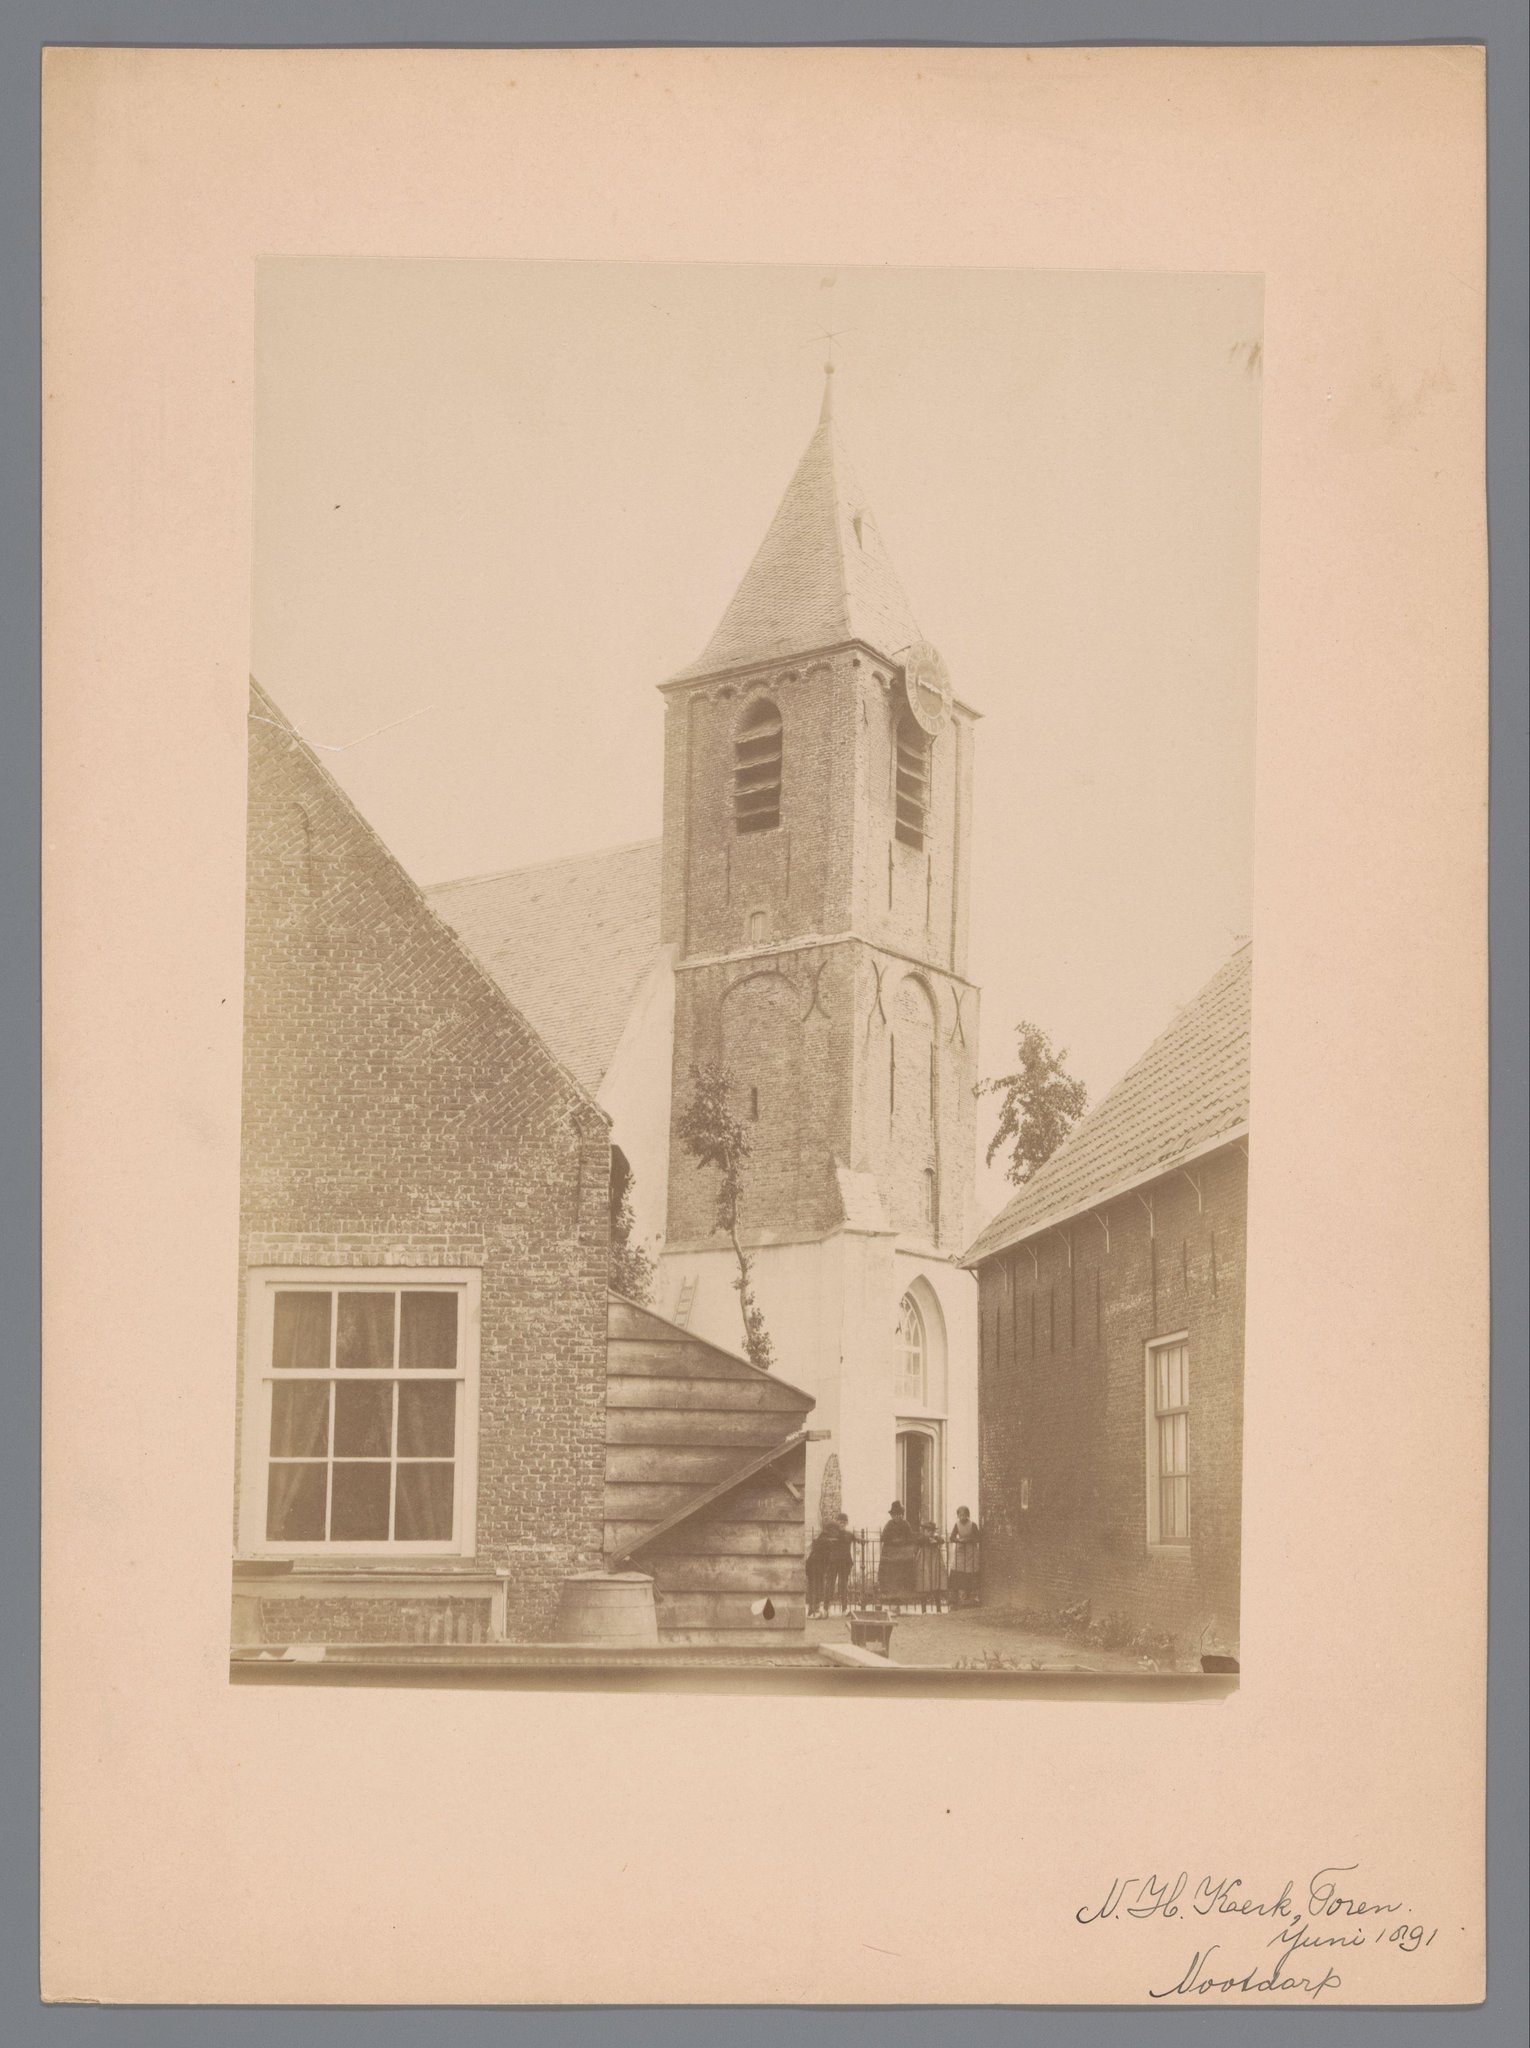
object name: photograph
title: Toren van de Dorpskerk van Nootdorp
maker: anoniem (monumentenzorg)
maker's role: fotograaf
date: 1891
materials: cardboard, photographic support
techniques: albumen print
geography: nootdorp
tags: street (+ city(-scape) with figures, staffage), parts of church exterior and annexes: tower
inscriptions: annotation: ‘Toren van de kerk v/d N.H. gemeente te Nootdorp/ juni 1891’, annotation: ‘N.H. Kerk, Toren/ Juni 1891/ Nootdorp’